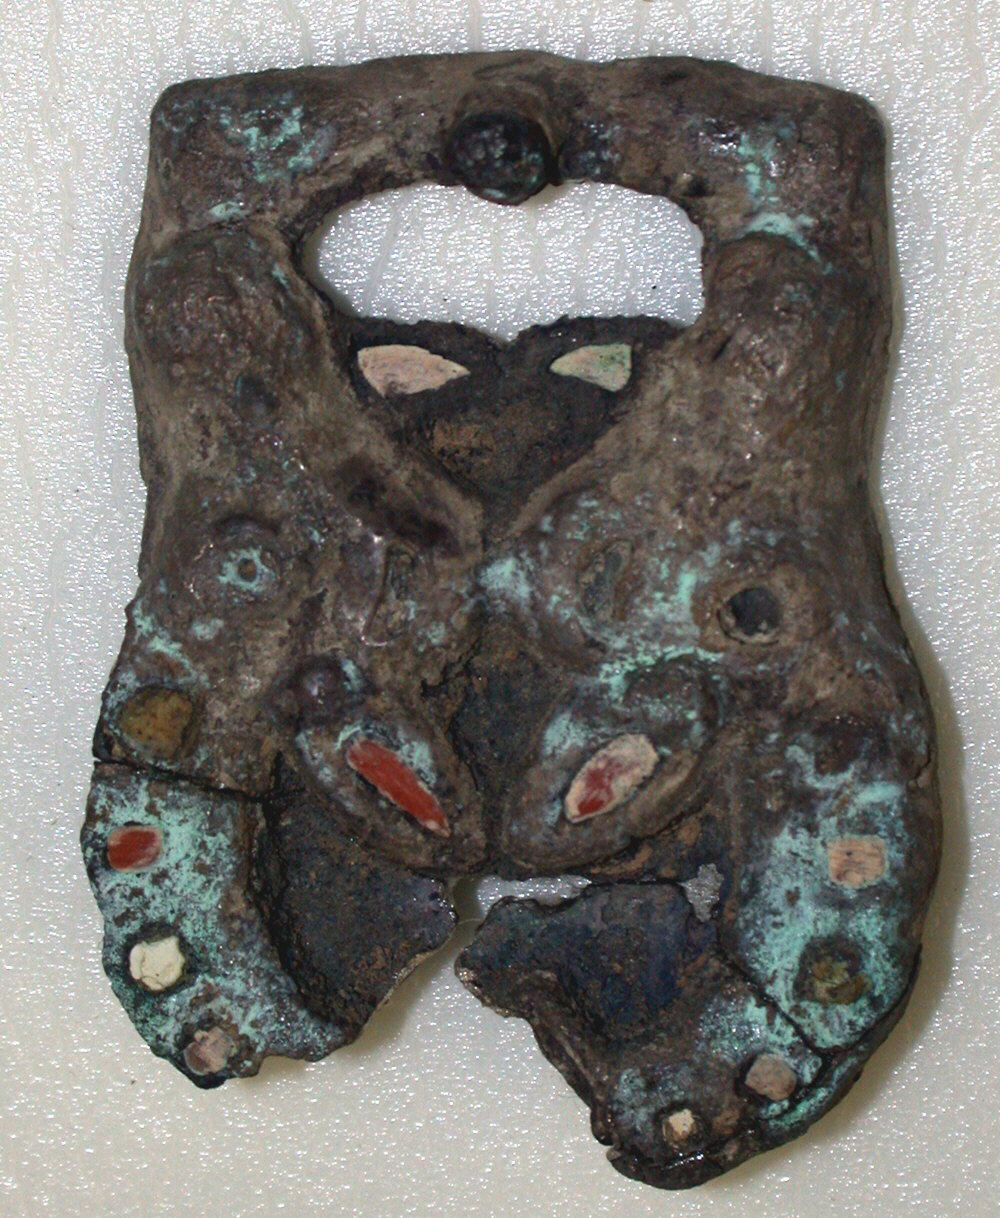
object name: buckle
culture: xiongnu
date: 300-101 BCE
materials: silver, stone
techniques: inlay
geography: eurasian steppes